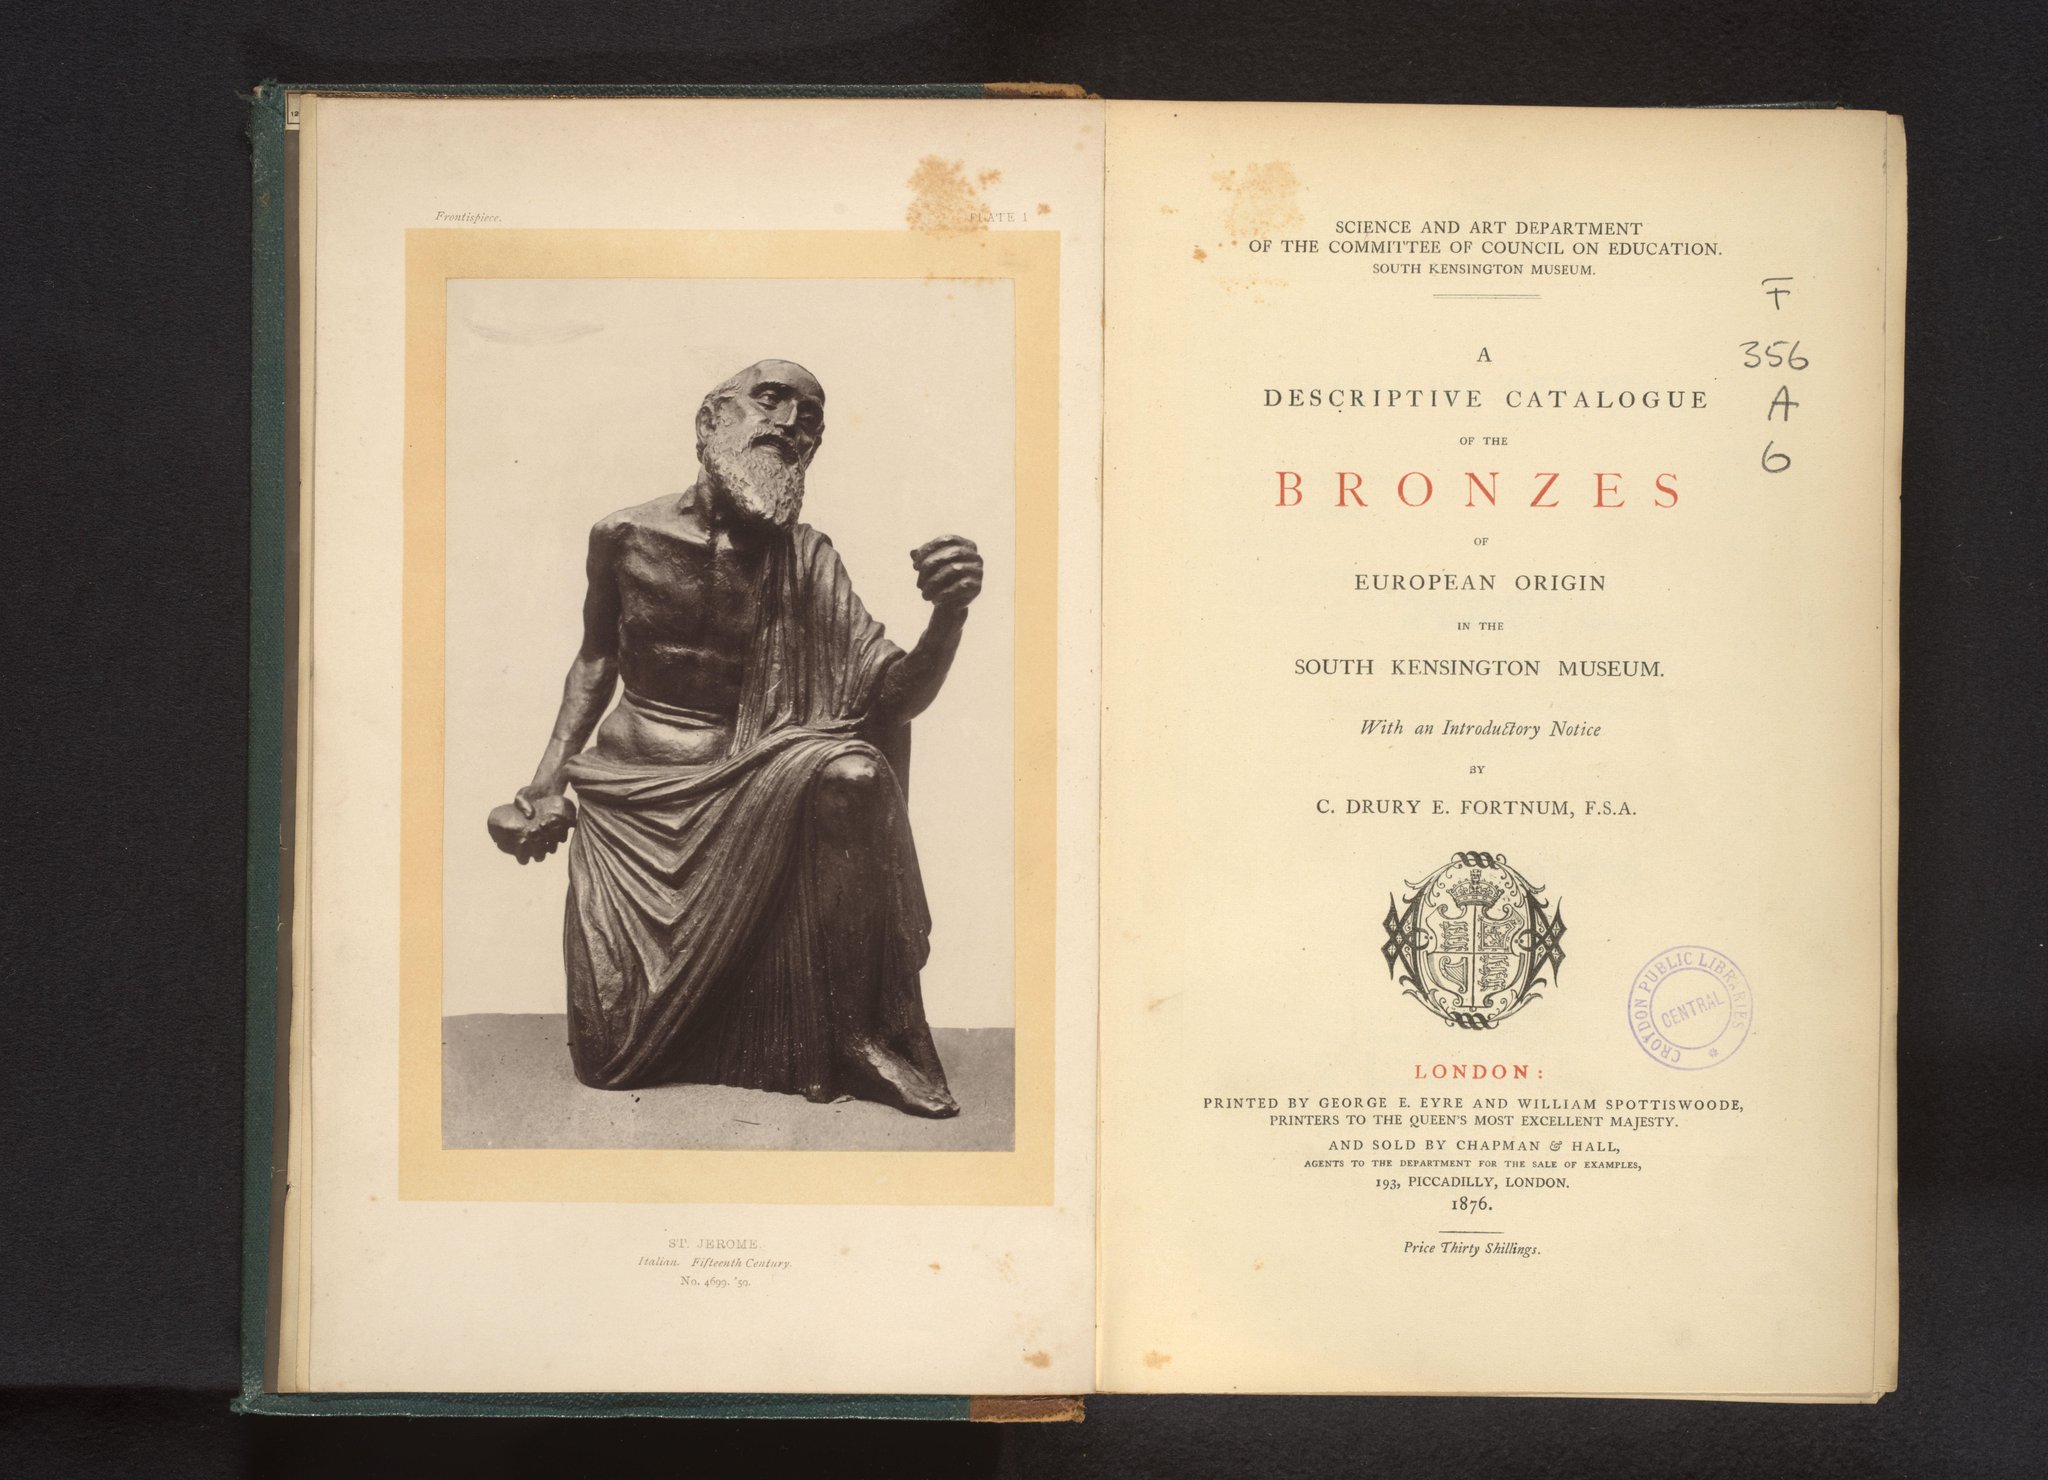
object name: book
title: A descriptive catalogue of the bronzes of European origin in the South Kensington Museum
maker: charles drury edward fortnum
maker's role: kunsthistoricus, verzamelaar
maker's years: 1820-1899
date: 1876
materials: cardboard, leather, linen, paper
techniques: etching, printing, woodburytype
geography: london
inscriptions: inscription: ‘Croydon Public Libraries Central Reference Library.’